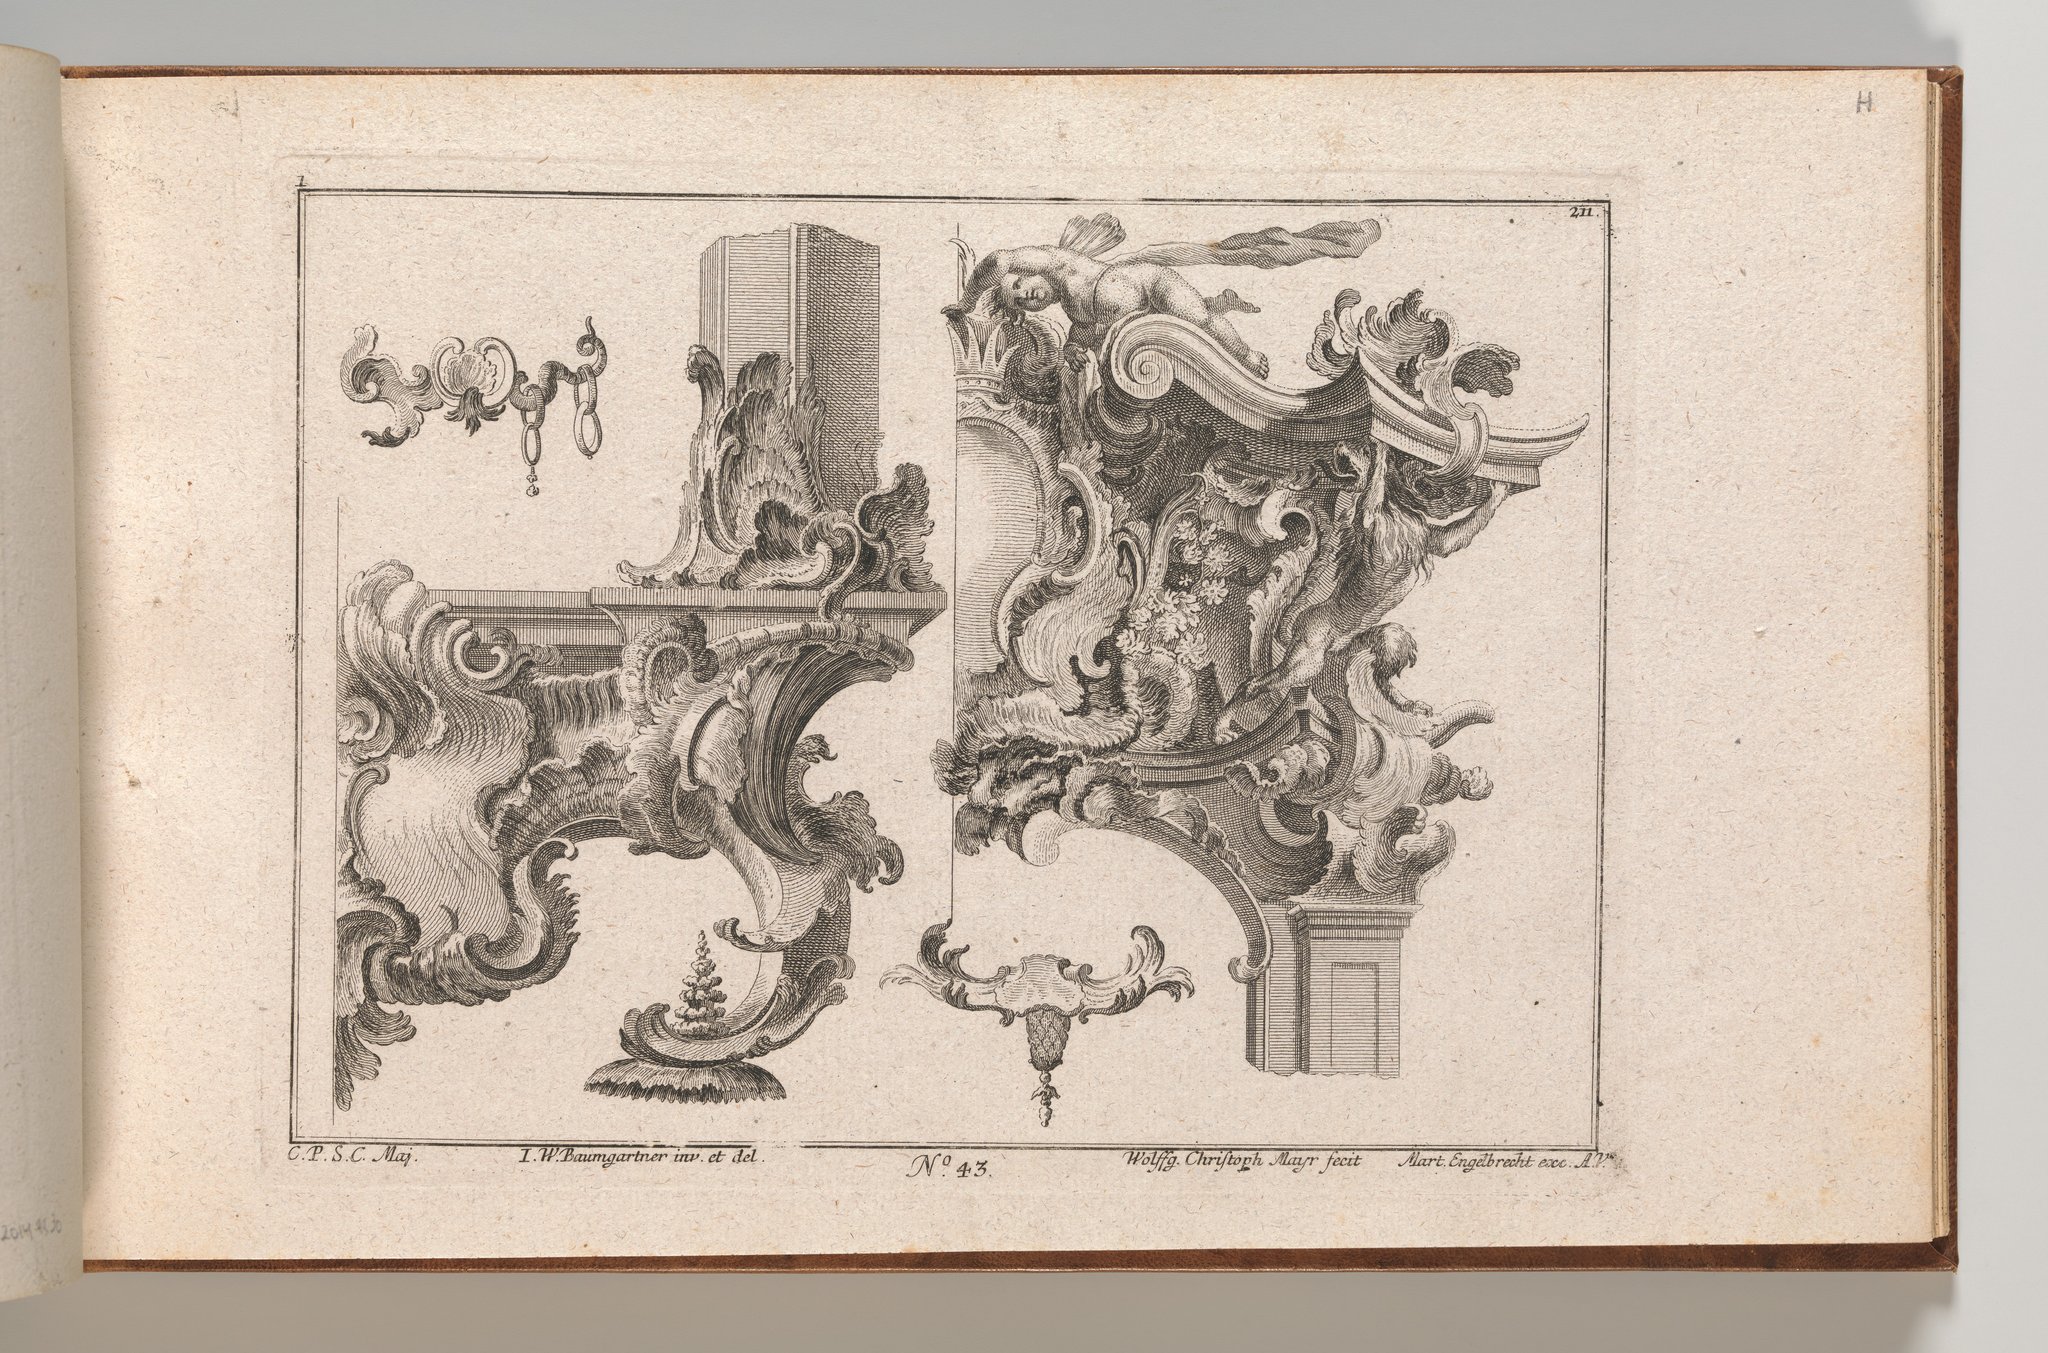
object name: album print ornament architecture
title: Suggestion for the Decoration of Lower Right and Top Right of an Altar Frame, Plate 1 from an Untitled Series with Rocailles Ornaments for Altar and Door Frames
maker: wolffgang christoph mayr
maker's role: engraver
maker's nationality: central european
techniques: etching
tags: cartouches,ornament